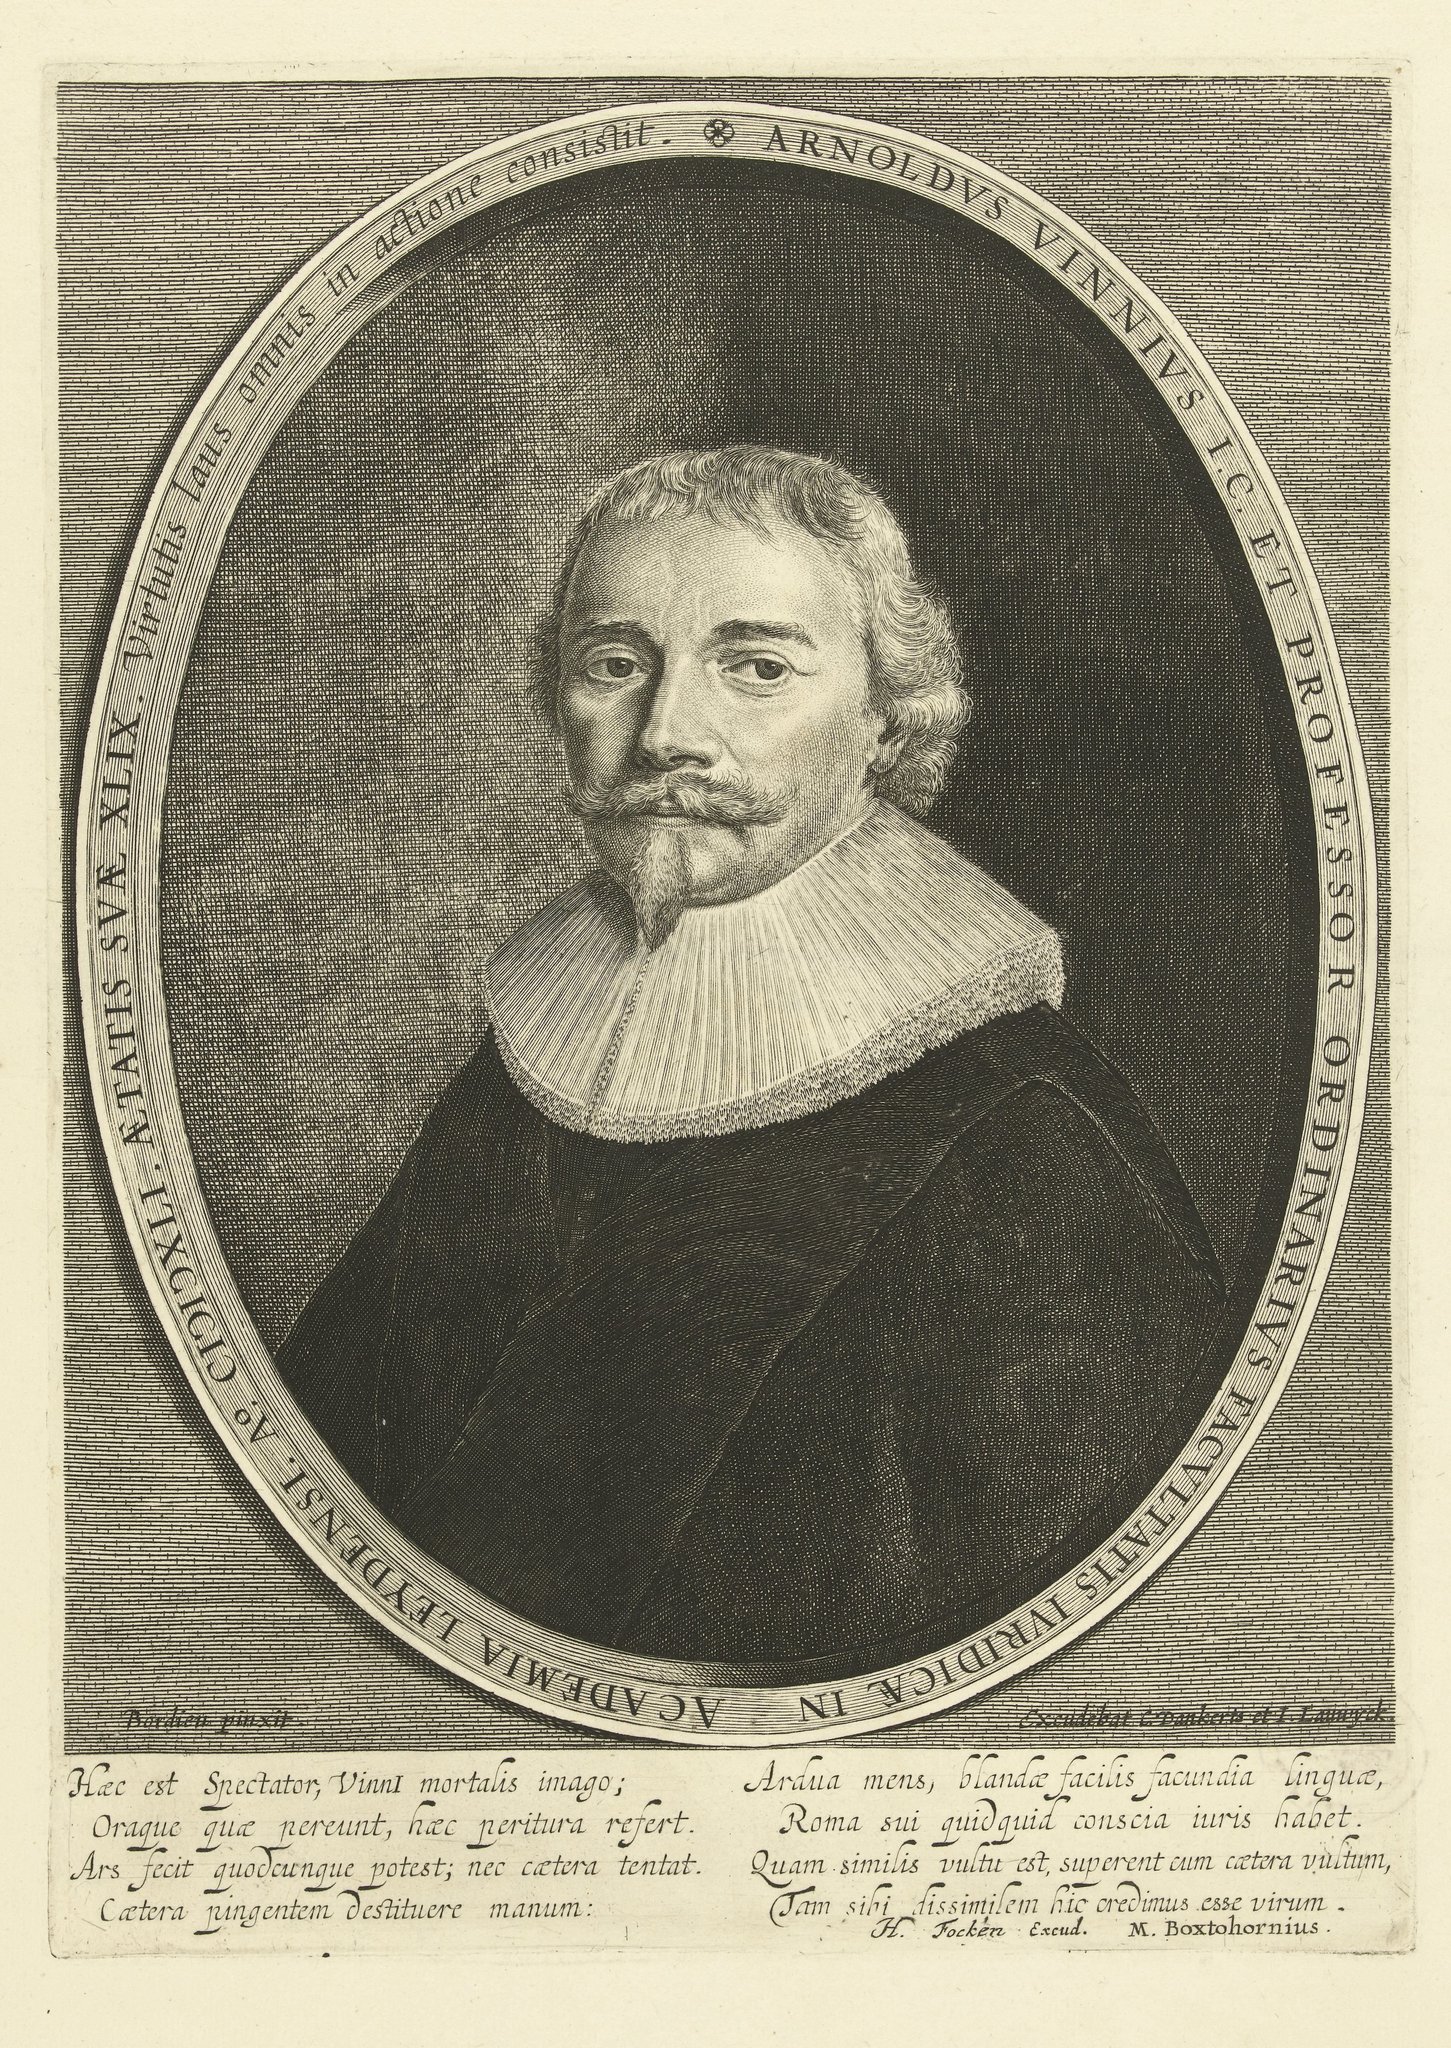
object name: print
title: Portret van Arnoldus Vinnius op 49-jarige leeftijd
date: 1641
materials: paper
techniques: engraving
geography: amsterdam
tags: professor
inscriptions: collector's mark: Lugt 240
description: Portret van Arnoldus Vinnius op 49-jarige leeftijd, professor aan de juridische faculteit Leiden. Borststuk in ovale omlijsting met motto Virtutis laus omnis in actione consistit. Onder in marge een Latijns vers van Marcus Zuerius Boxhorn.